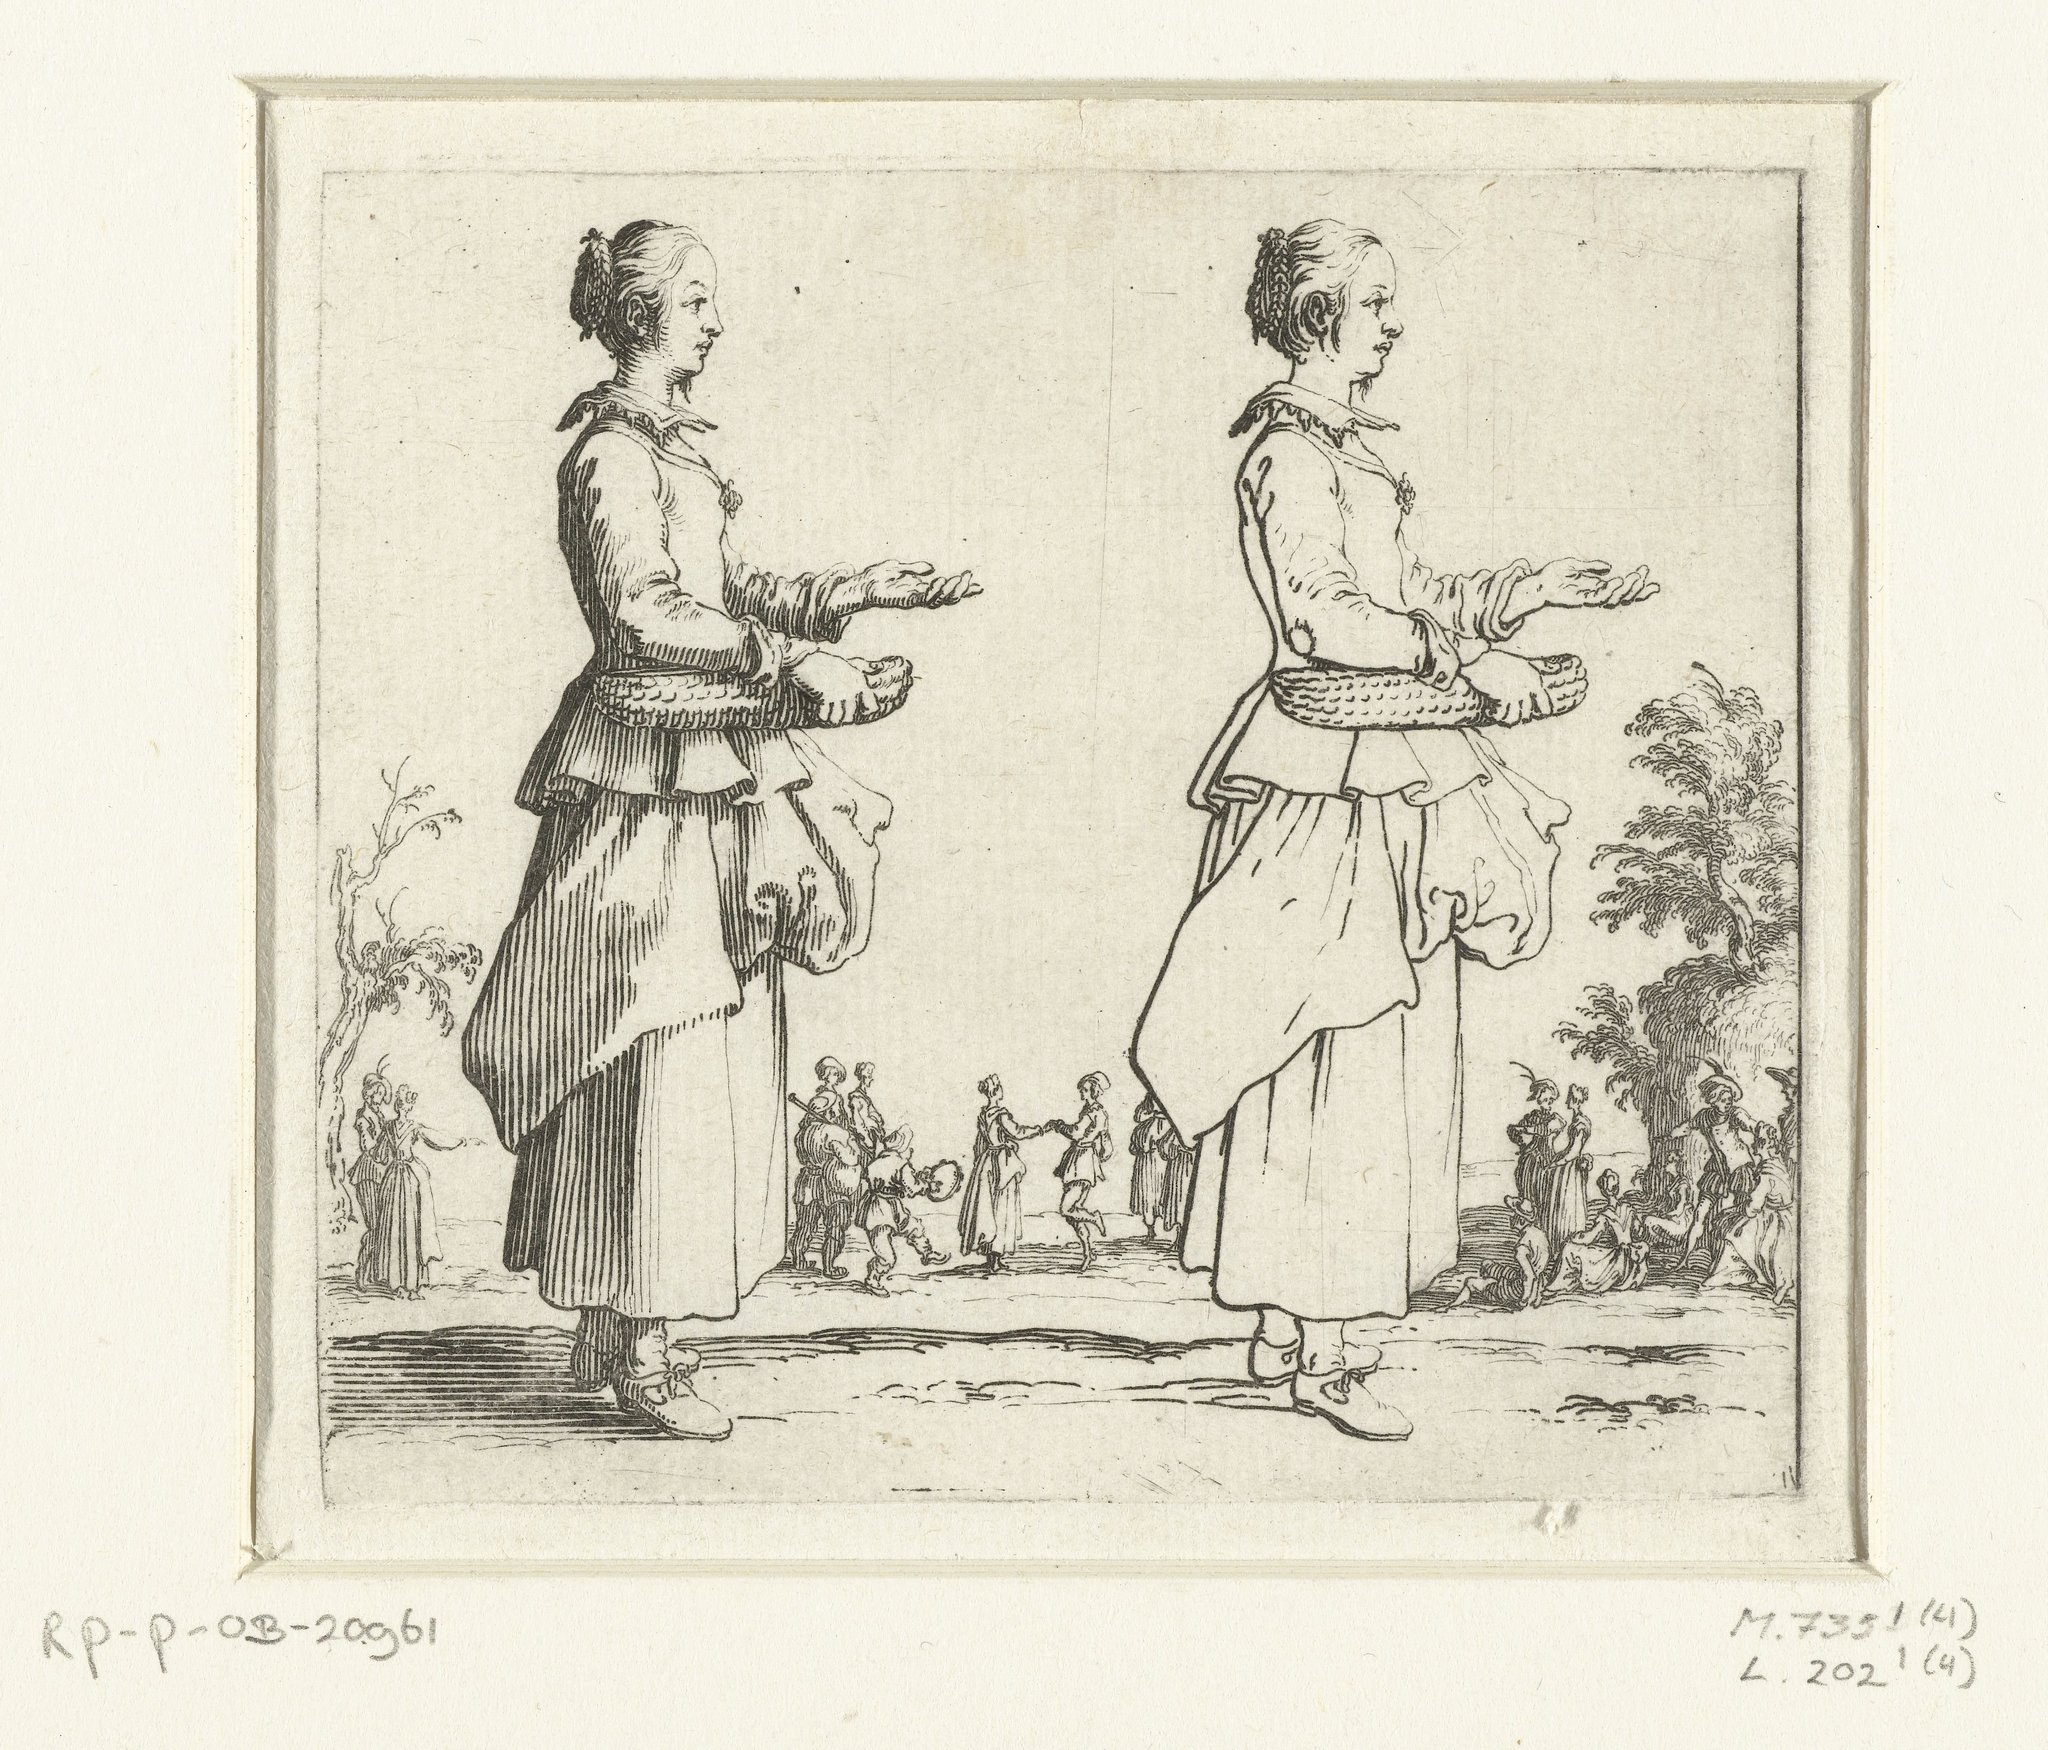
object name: print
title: Varie figure di Jacopo Callot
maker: jacques callot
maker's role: draughtsman, print maker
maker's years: 1592-1635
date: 1621-1624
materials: paper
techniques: etching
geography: nancy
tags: farmers - aa - female farmer, farmer's wife, container made of plant material other than wood: basket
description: Een boerin met een rieten mand in de rechterhand, de linkerhand bedelend ophoudend, op de rechterzijde gezien, tweemaal afgebeeld: rechts als lijnfiguur, links meer uitgewerkt met schaduwpartijen. Op de achtergrond enkele dansende en musicerende figuurtjes en toeschouwers. Deze prent is onderdeel van een serie van 16 prenten (15 volgens Lieure; 17 resp. 16 incl. titelprent) met mannen en vrouwen in diverse houdingen. Mogelijk zijn deze prenten bedoeld geweest als tekenvoorbeelden.